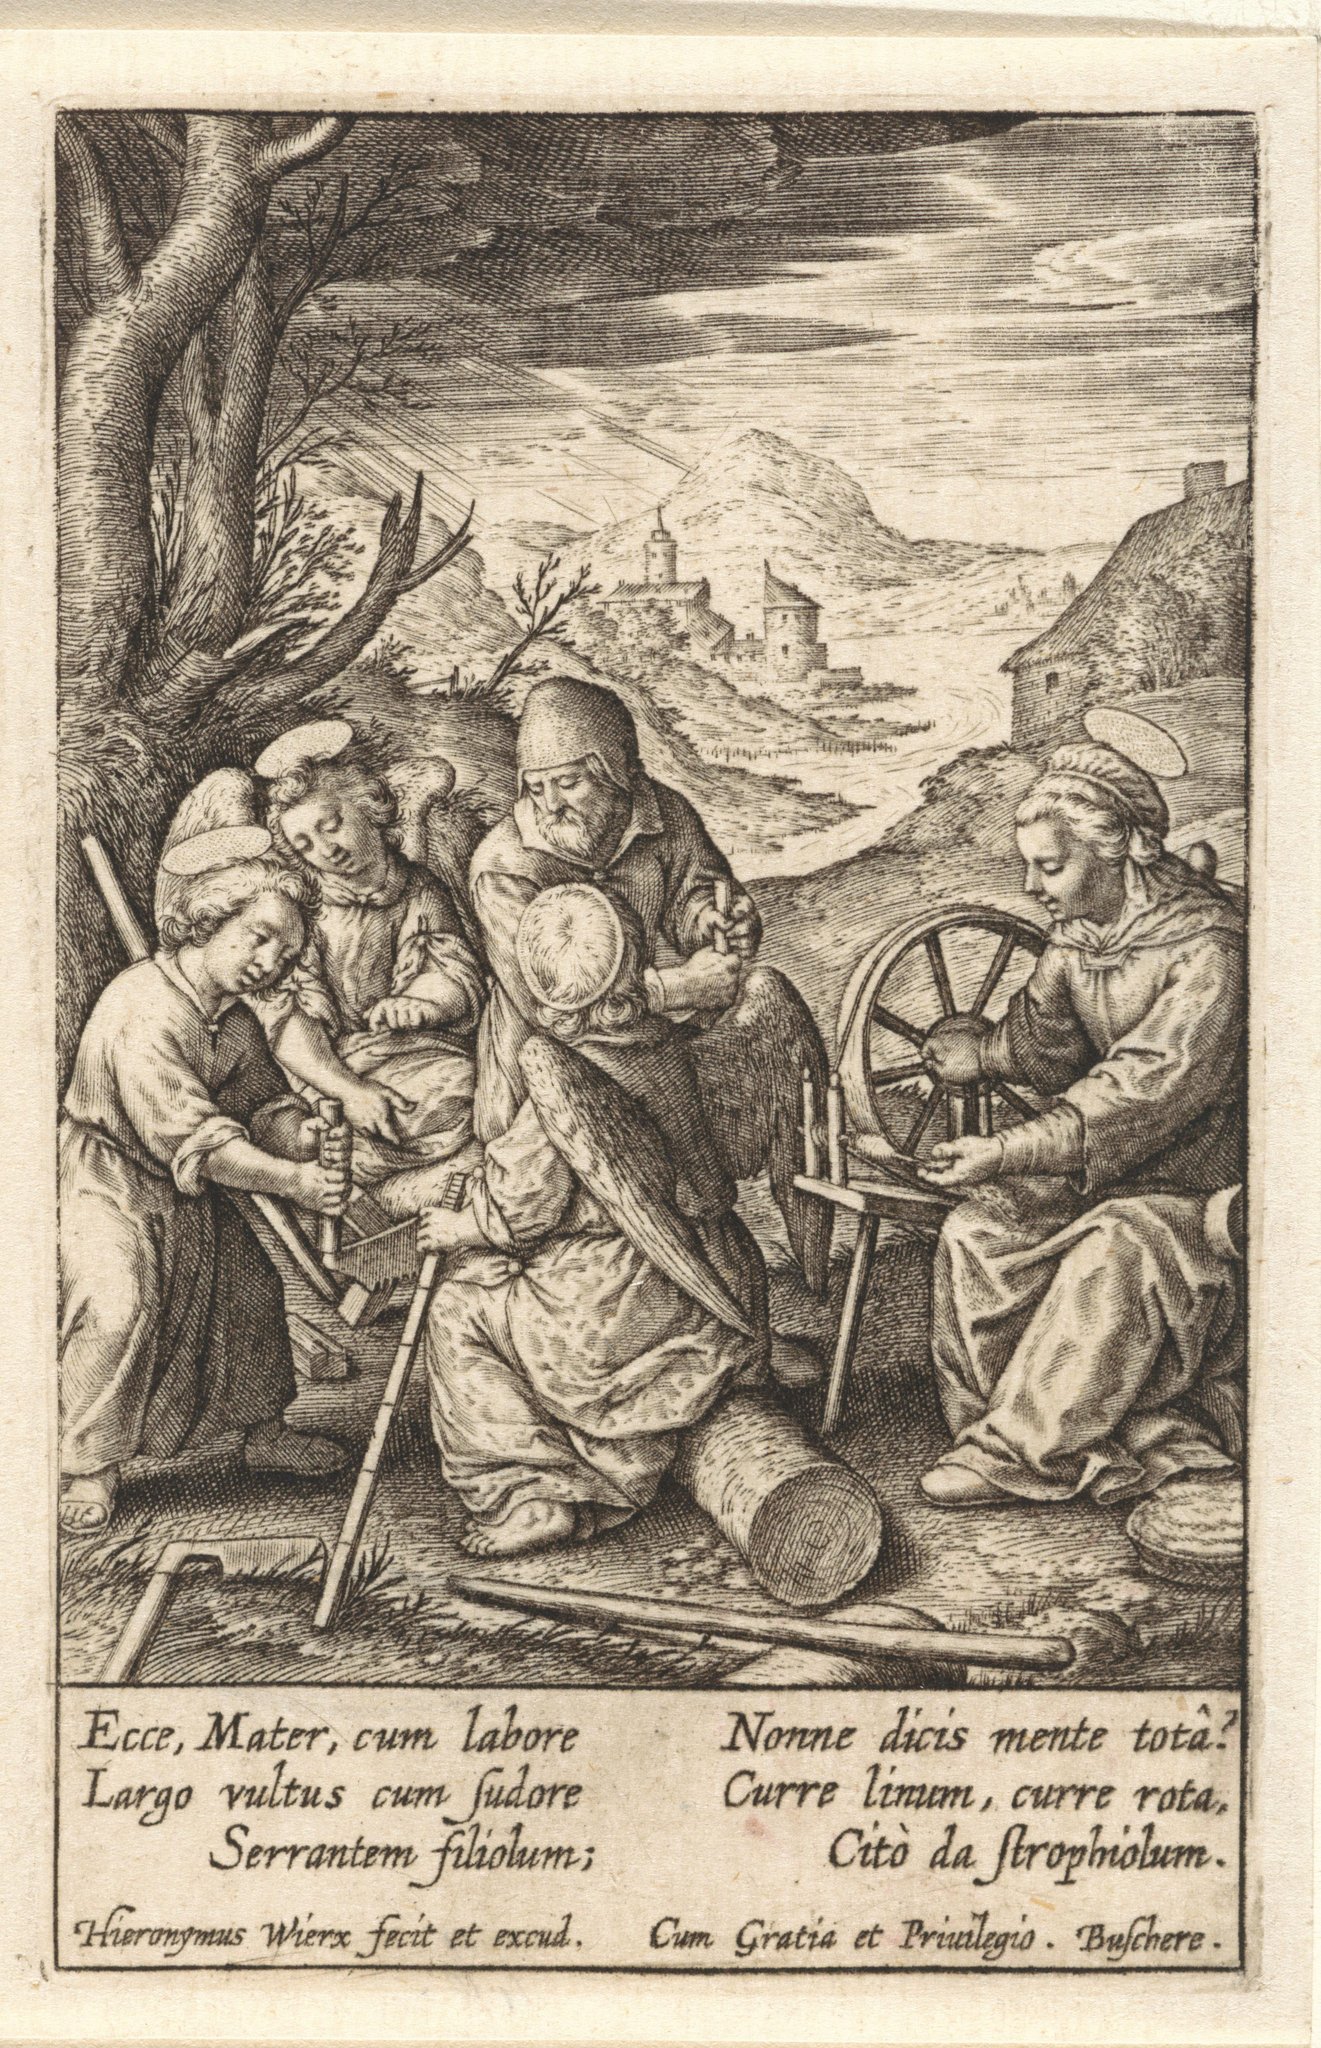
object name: print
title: Jeugd van Christus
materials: paper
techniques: engraving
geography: antwerp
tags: joseph and the christ-child ~ daily life in nazareth, household occupations of mary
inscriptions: number: ‘46’, collector's mark: Lugt 240, collector's mark: Lugt 2228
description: Het Christuskind, geholpen door twee engelen, zaagt een boomstam in stukken. Zijn vader Jozef kijkt toe. Maria is aan het spinnen. In de marge een zesregelig onderschrift, in twee kolommen, in het Latijn.